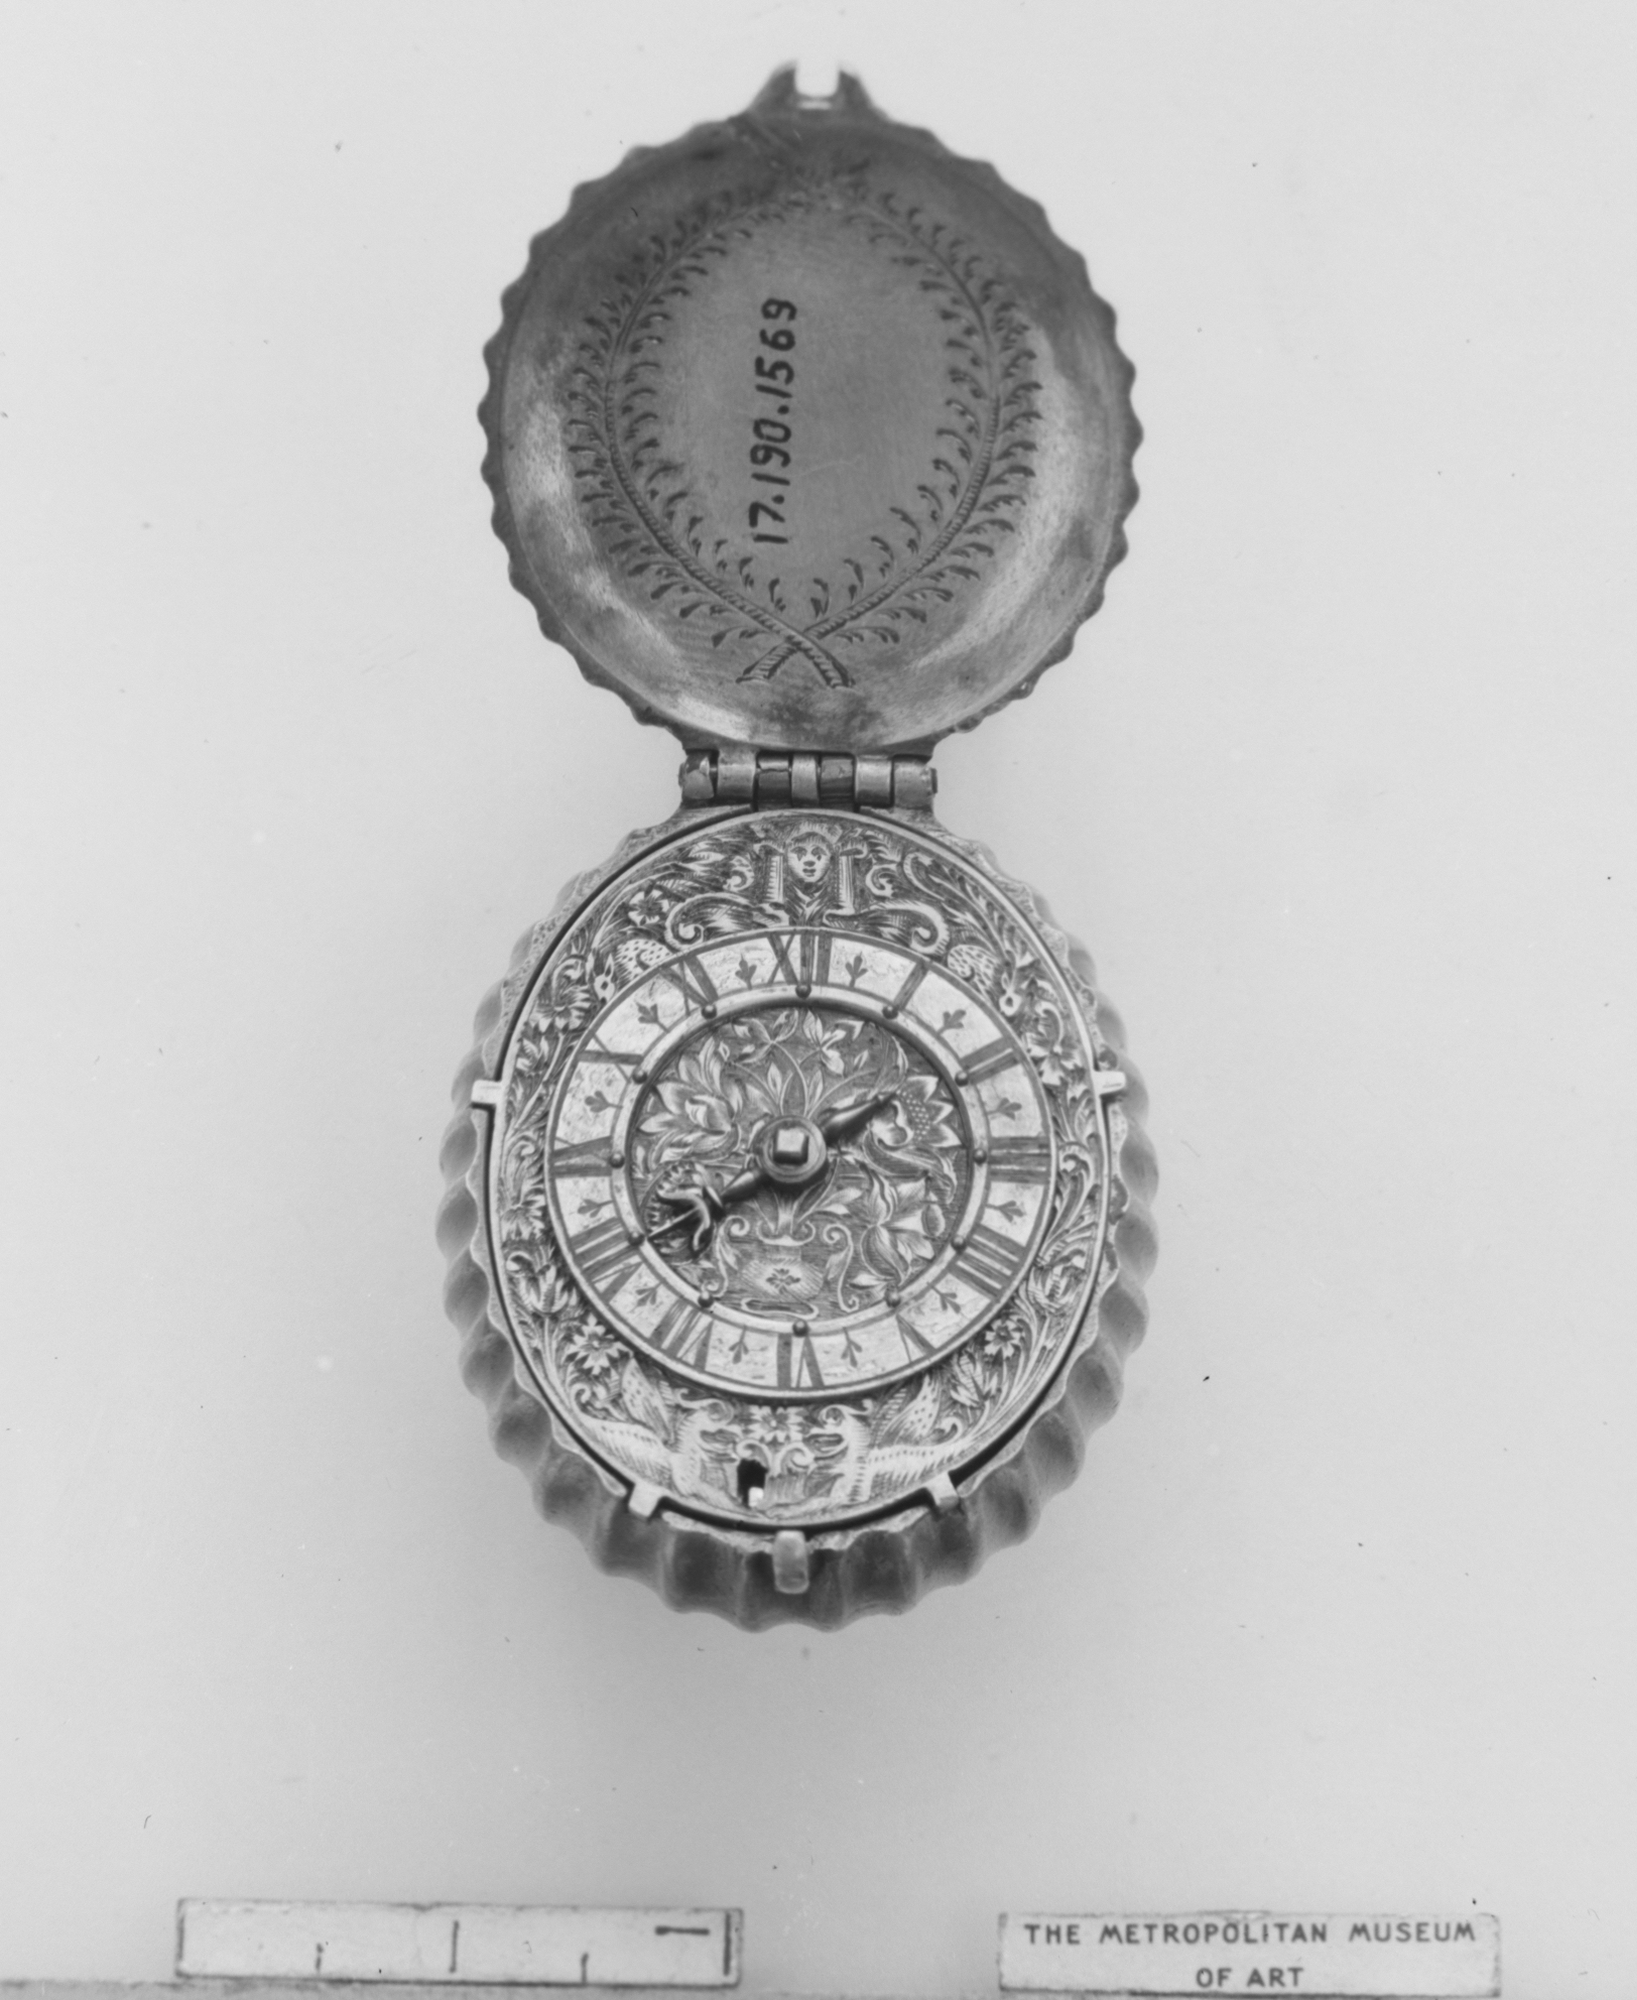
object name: watch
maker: denis bordier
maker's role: maker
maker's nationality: swiss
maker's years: 1629-1708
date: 1650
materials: gilt brass, silver, steel